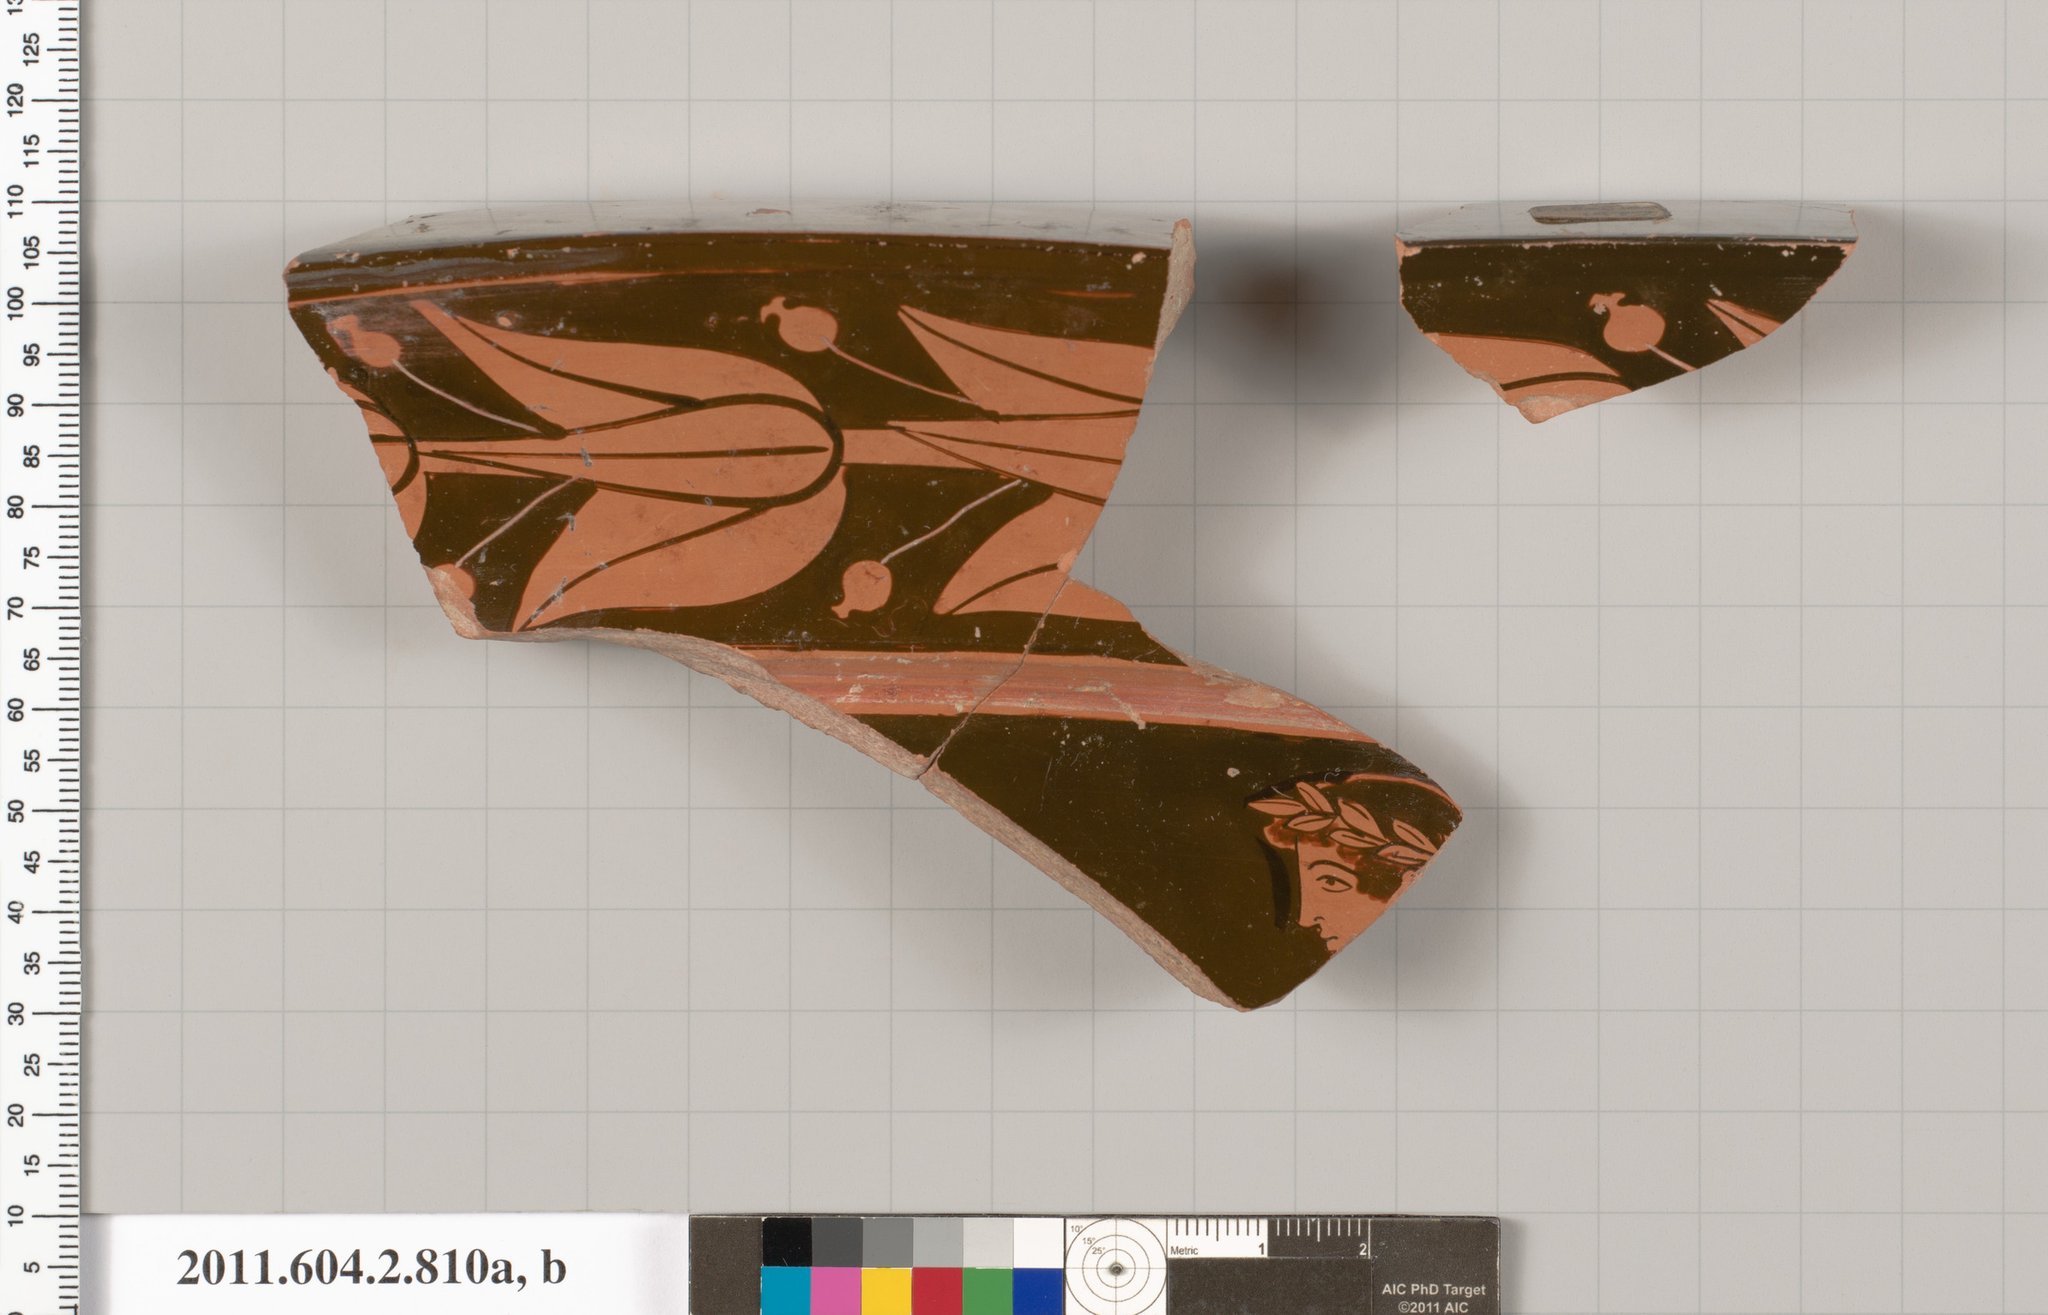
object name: bell krater fragment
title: Terracotta fragments of a bell-krater (bowl for mixing wine and water)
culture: greek, attic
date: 470-460 BCE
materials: terracotta